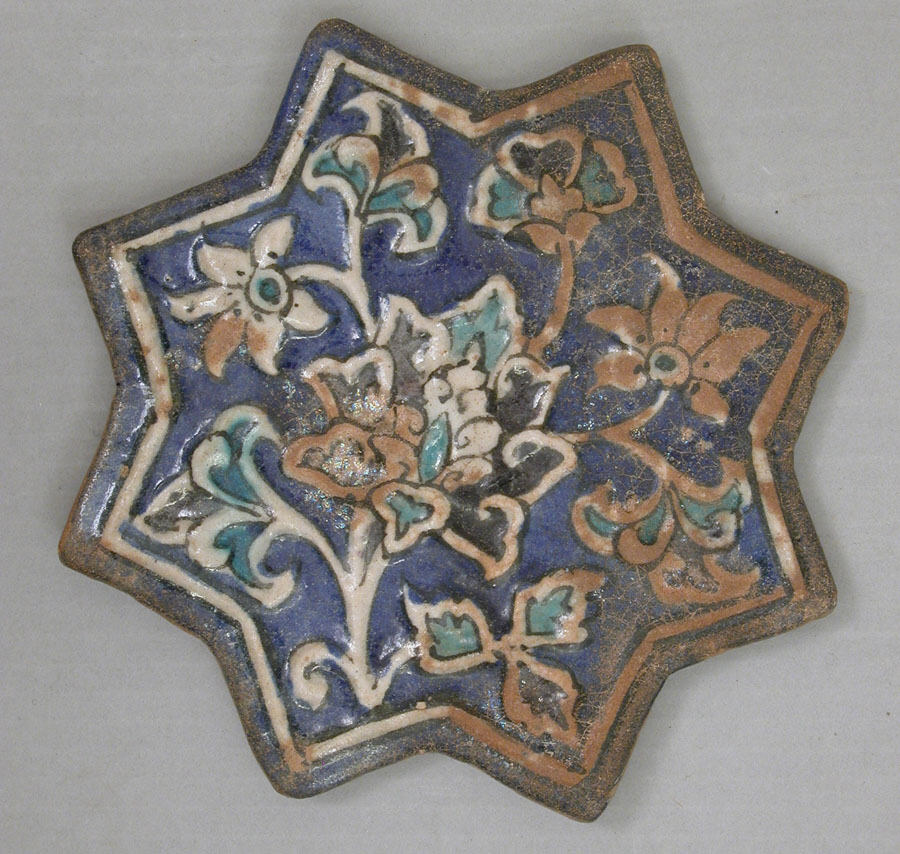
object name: tile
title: Star-Shaped Tile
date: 1301-1350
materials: stonepaste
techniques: molding, painting, underglaze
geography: iran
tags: flowers